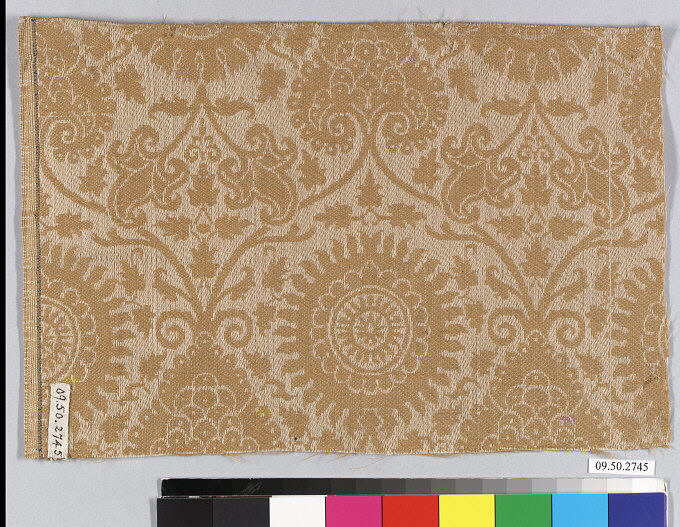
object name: piece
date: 1801-1900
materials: silk